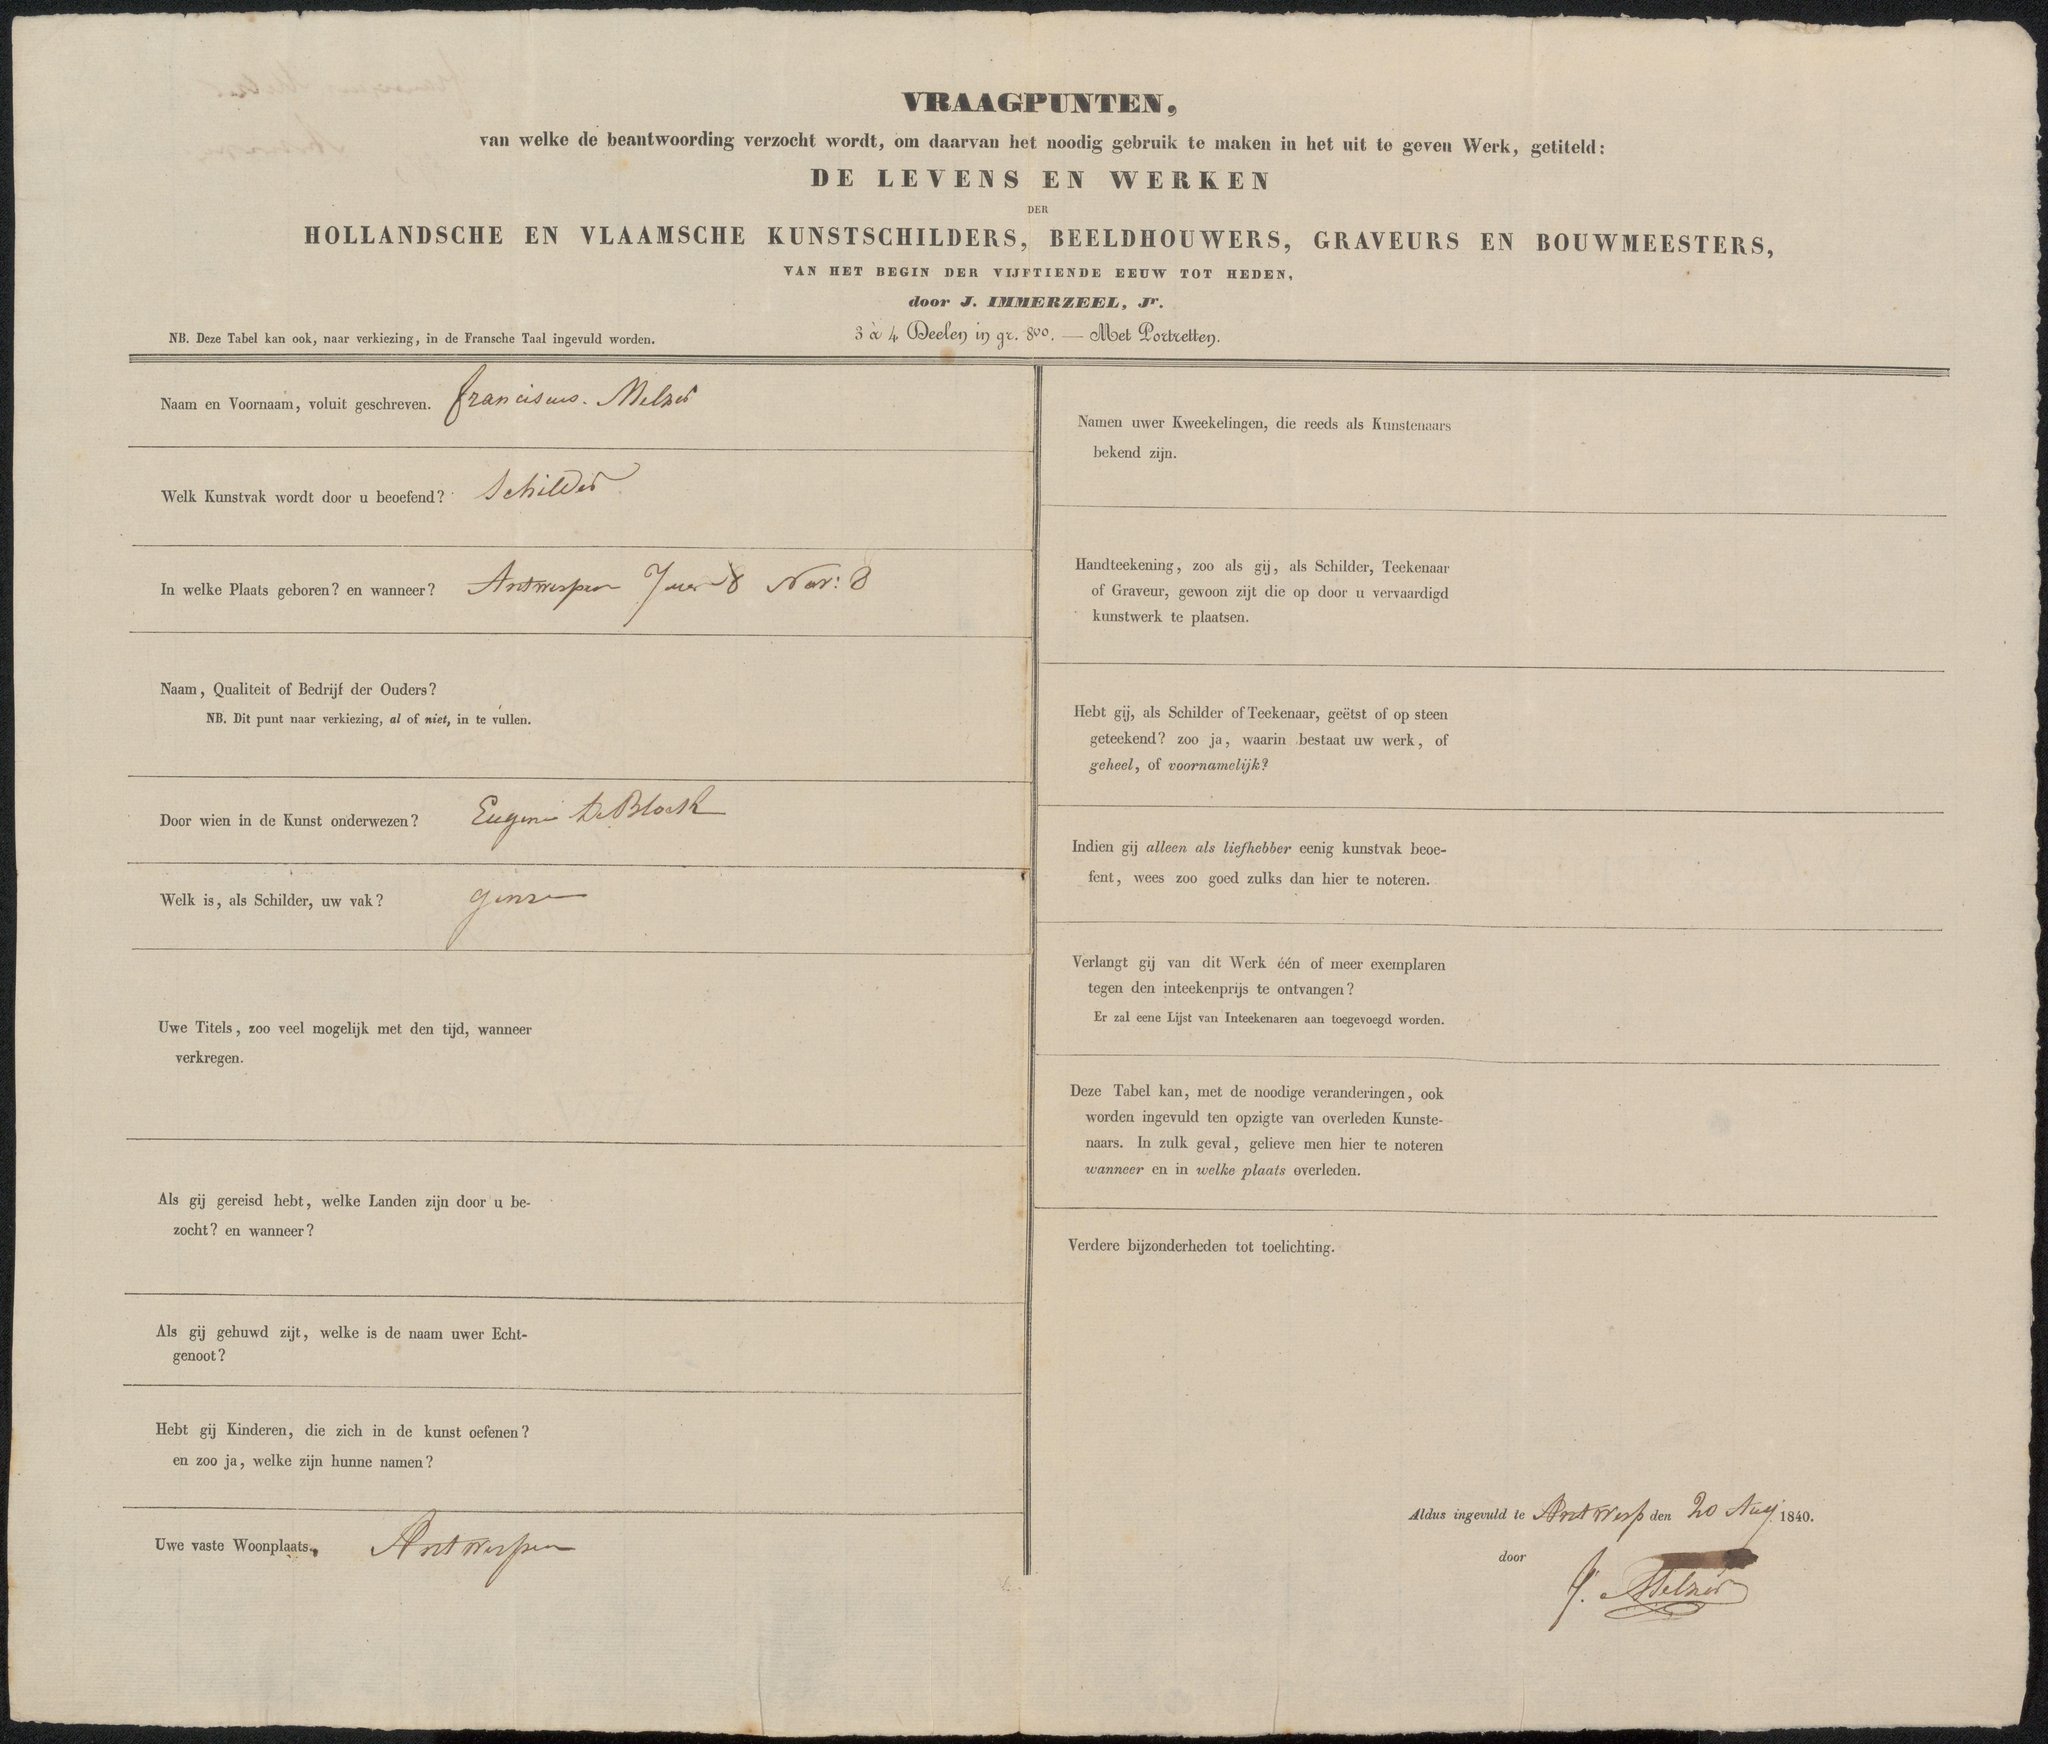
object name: questionnaire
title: Enquêteformulier ingevuld door Frans Melzer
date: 1840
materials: ink, paper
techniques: pen, printing, writing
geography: antwerp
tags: painter, frans melzer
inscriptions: inscription: ‘Vraagpunten,/ van welke de beantwoording verzocht wordt, om daarvan het noodig gebruik te maken in het uit te geven Werk, getiteld: De levens en werken/ der Hollandsche en Vlaamsche kunstschilders, beeldhouwers,/ graveurs en bouwmeesters, van het begin der vijftiende eeuw tot heden/ door J. Immerzeel, Jr.’, watermark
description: Opgenomen in: Immerzeel, J. Jr., De levens en werken der Hollandsche en Vlaamsche kunstschilders, beeldhouwers, graveurs en bouwmeesters, van het begin der vijftiende eeuw tot heden, Amsterdam: J.C. van Kesteren, 1842-1843.